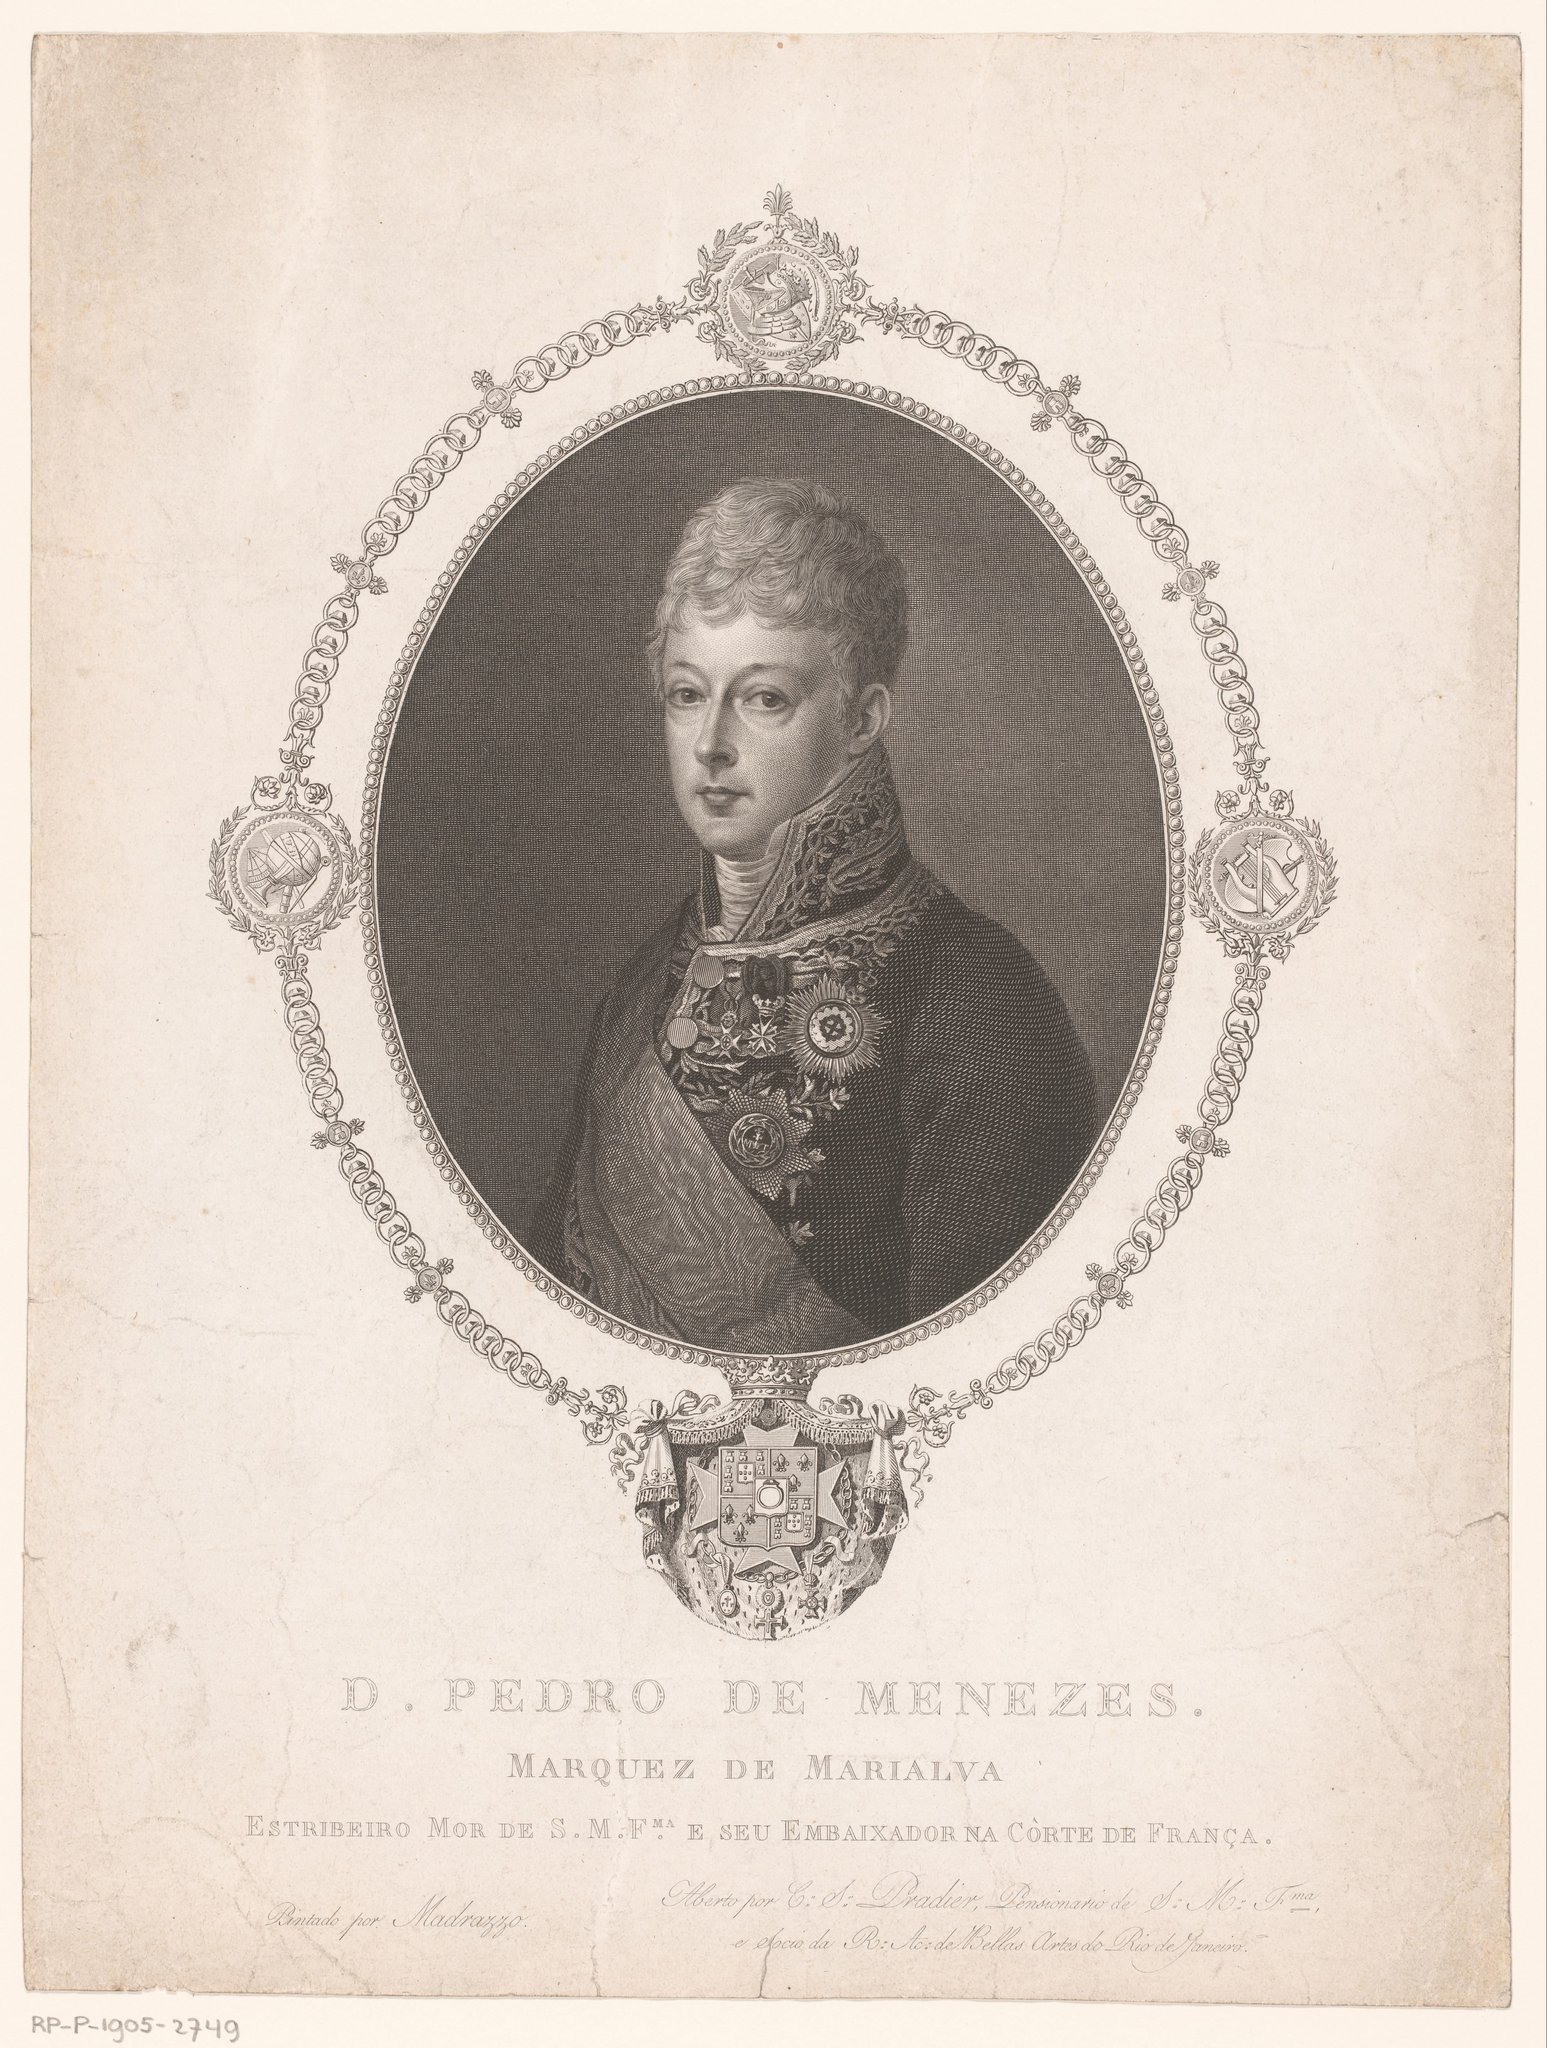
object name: print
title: Portret van Pedro José de Meneses Coutinho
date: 1793-1847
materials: paper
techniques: engraving, etching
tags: historical persons, ambassador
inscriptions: collector's mark: Lugt 2228